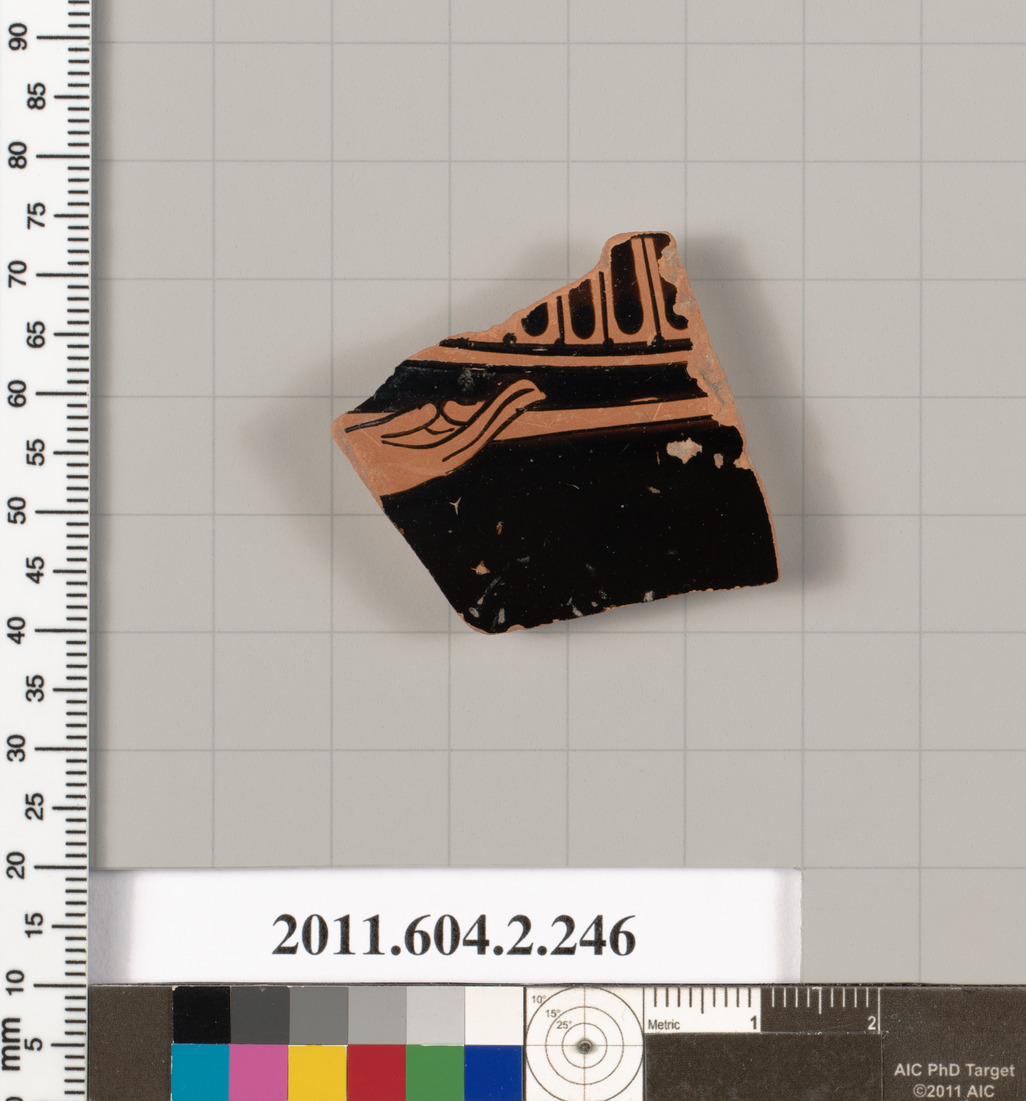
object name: stamnos fragment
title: Terracotta fragment of a stamnos (jar)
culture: greek, attic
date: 490-480 BCE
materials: terracotta